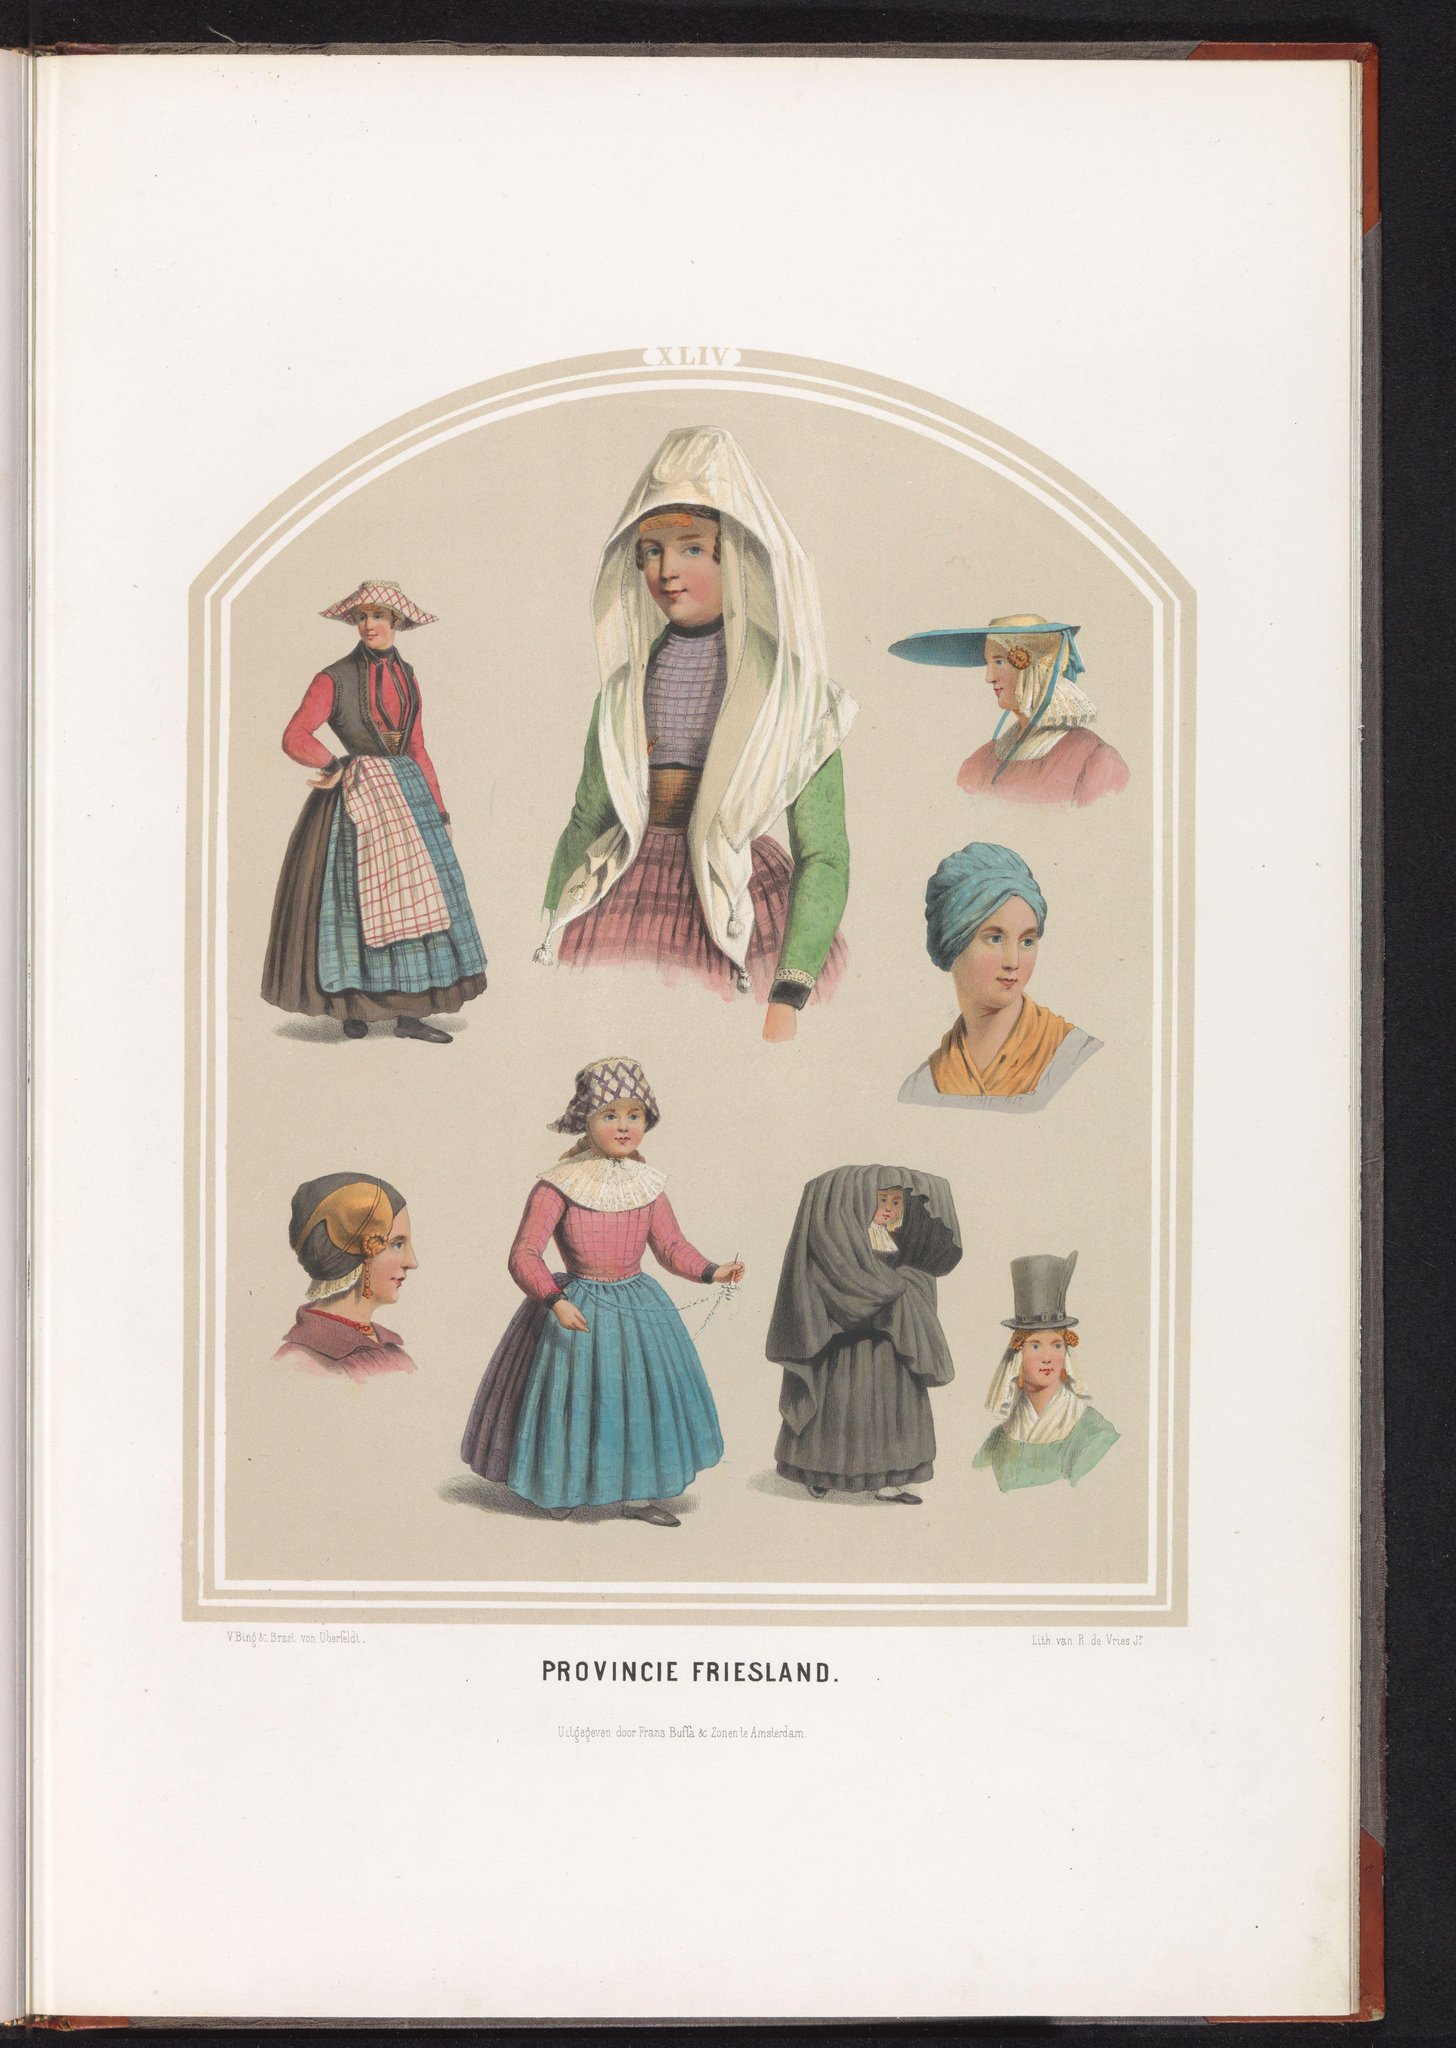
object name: print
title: Provincie Friesland / XLIV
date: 1857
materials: paper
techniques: hand coloring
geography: netherlands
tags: folk costume, regional costume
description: Klederdracht in de provincie Friesland. Verschillende losse studies. Illustratie in een boek uit 1857 met 56 platen van Nederlandse klederdrachten.